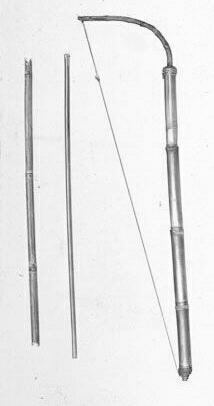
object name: musical bow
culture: south african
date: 1867-1900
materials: bamboo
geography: south africa